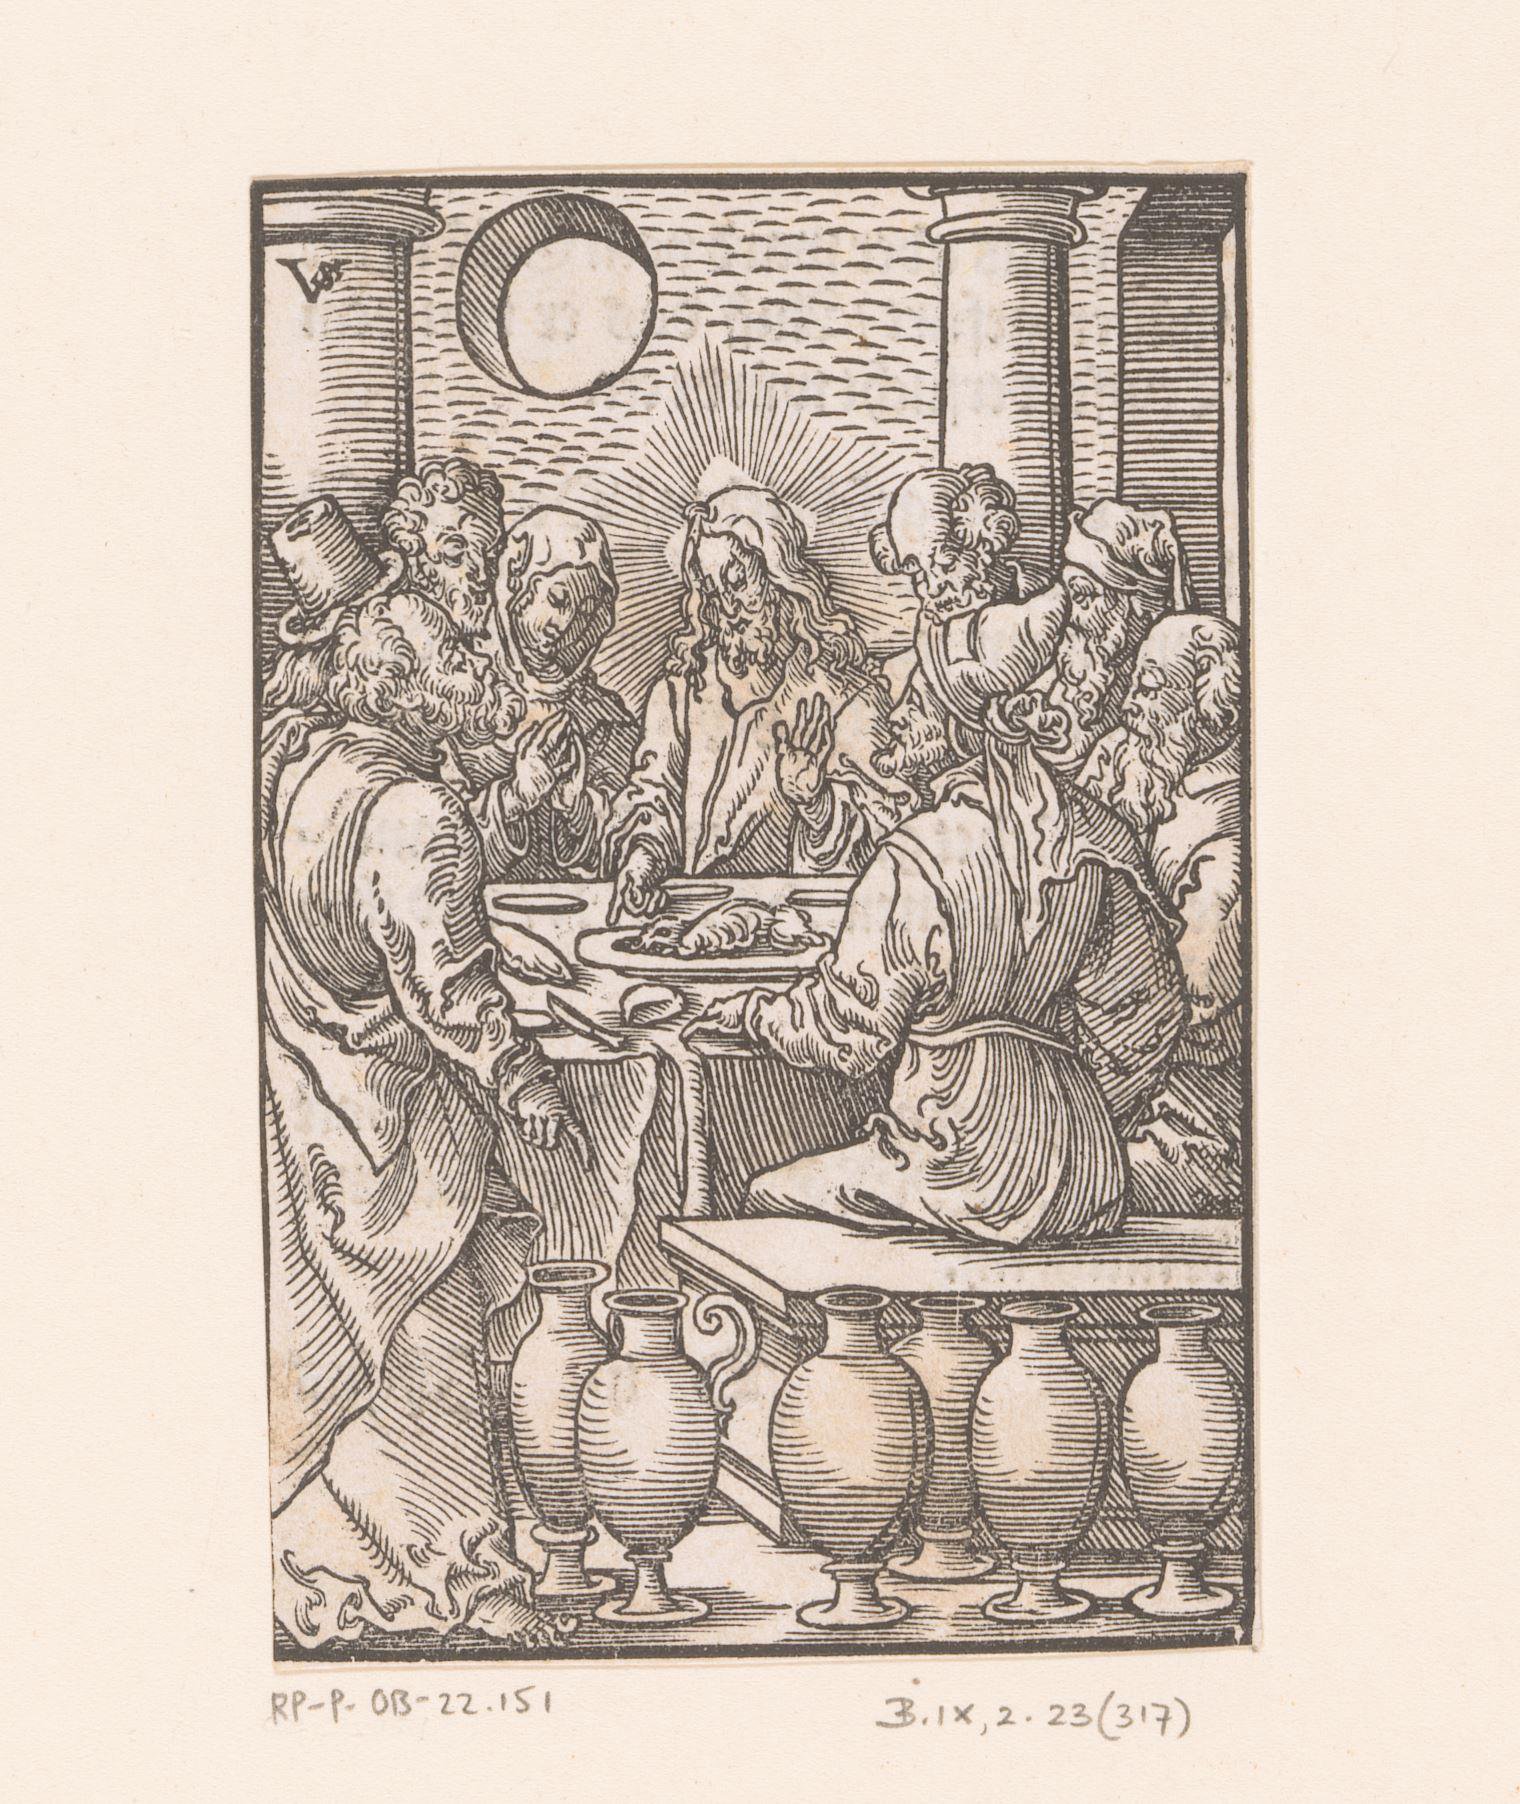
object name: print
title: Bruiloft te Kana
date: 1552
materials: paper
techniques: woodcut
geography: nuremberg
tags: christ orders (six) jars to be filled with water ~ marriage-feast at cana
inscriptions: number: ‘181’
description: Gebruikt voor verschillende publicaties die werden gedrukt door Valentin Geißler tussen 1552 en 1560 te Neurenberg.